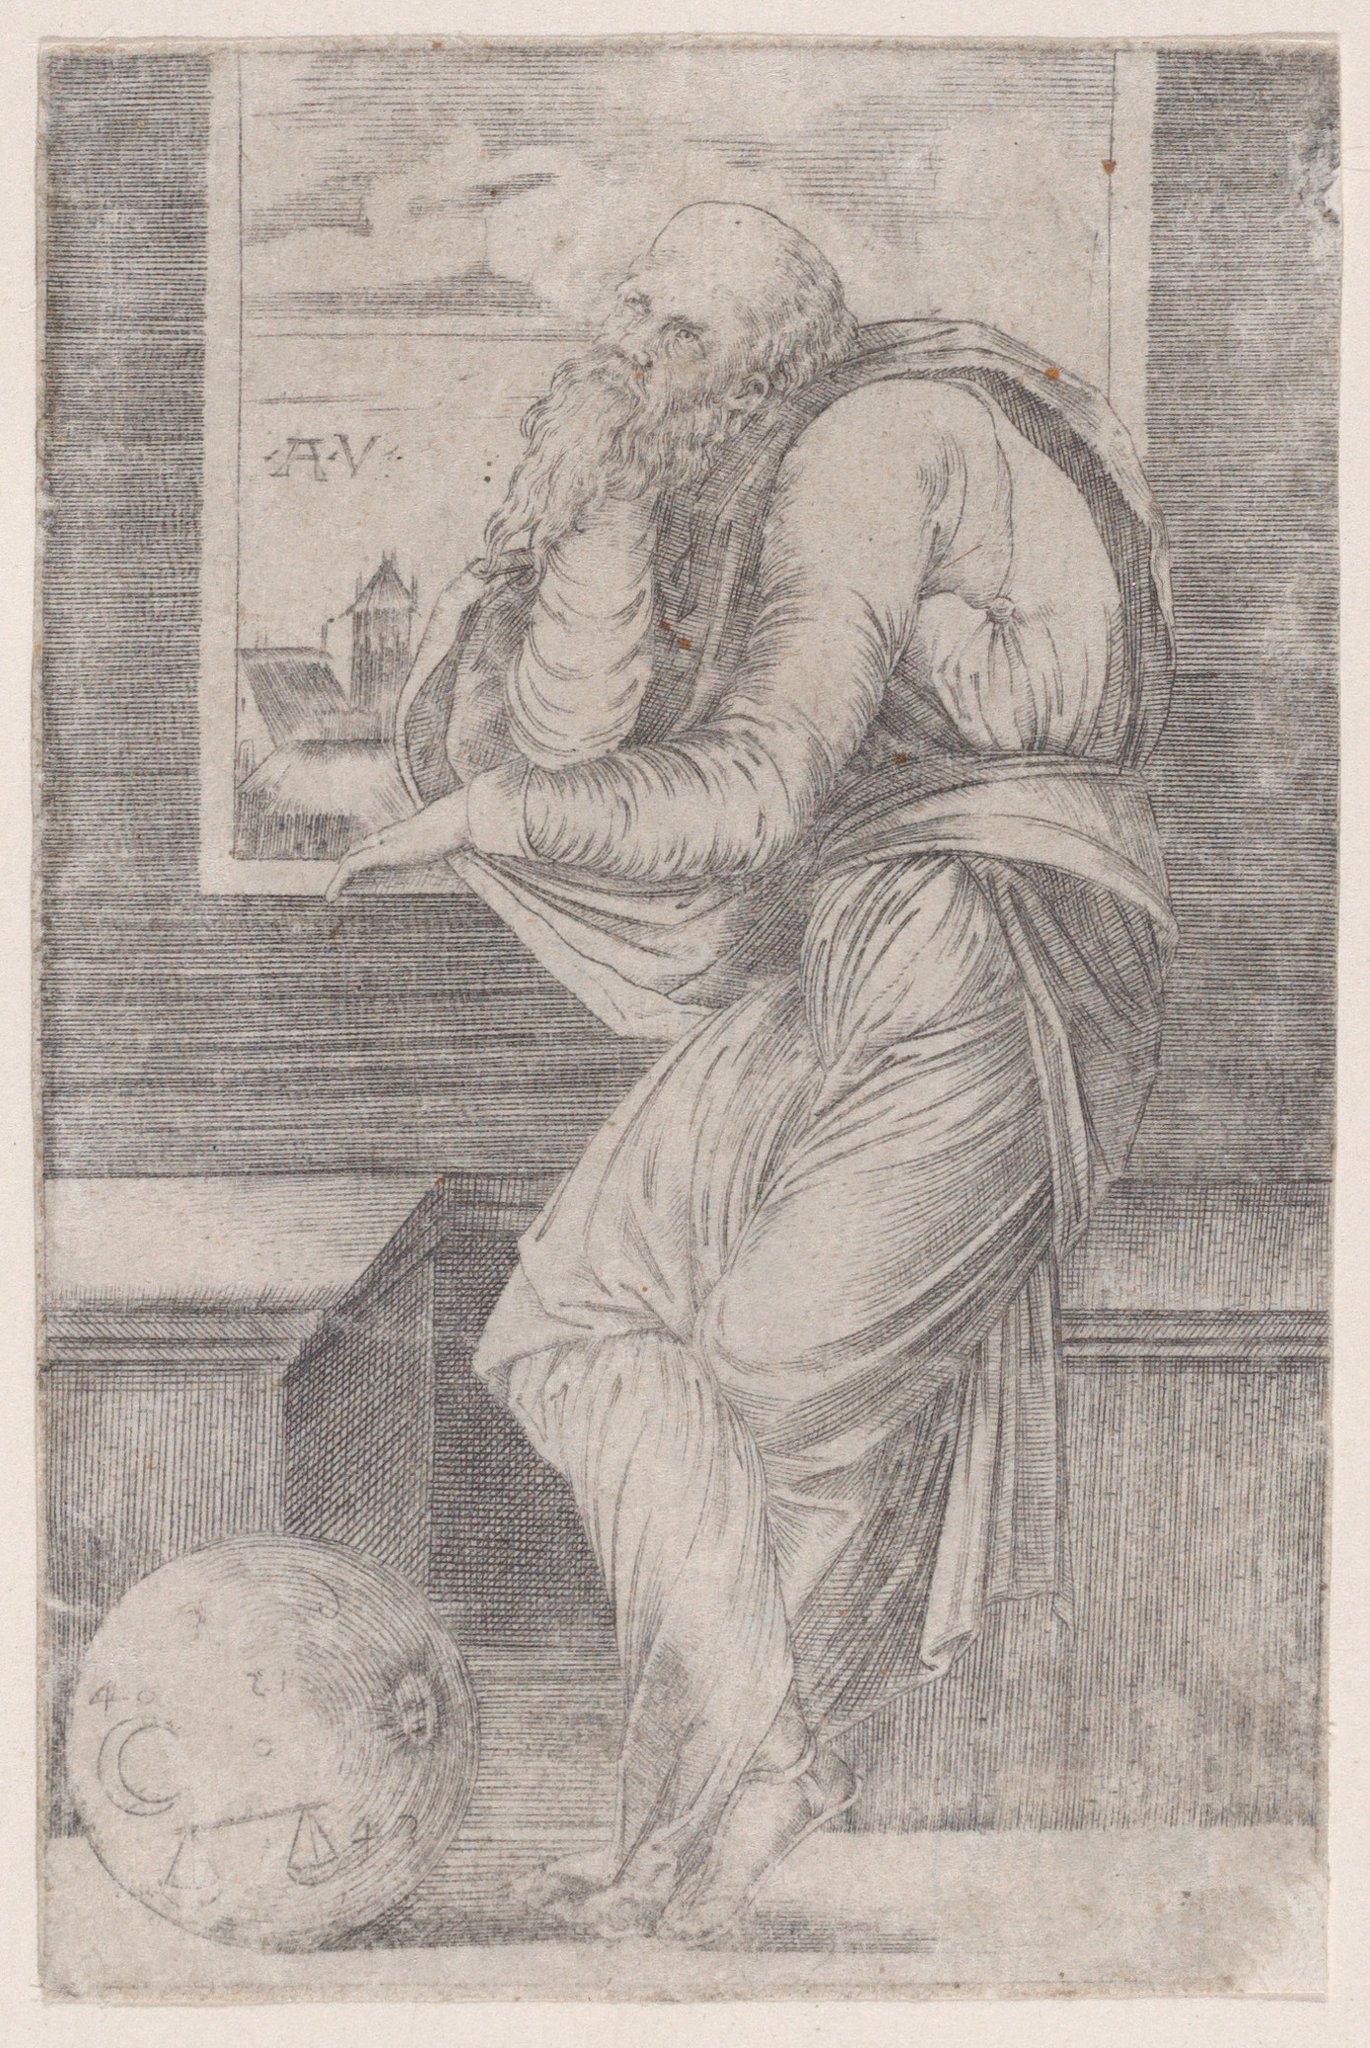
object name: print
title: Philoshopher Seated near a Window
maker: agostino veneziano (agostino dei musi)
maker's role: artist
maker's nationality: italian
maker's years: 1490-1536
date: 1514-1536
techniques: engraving